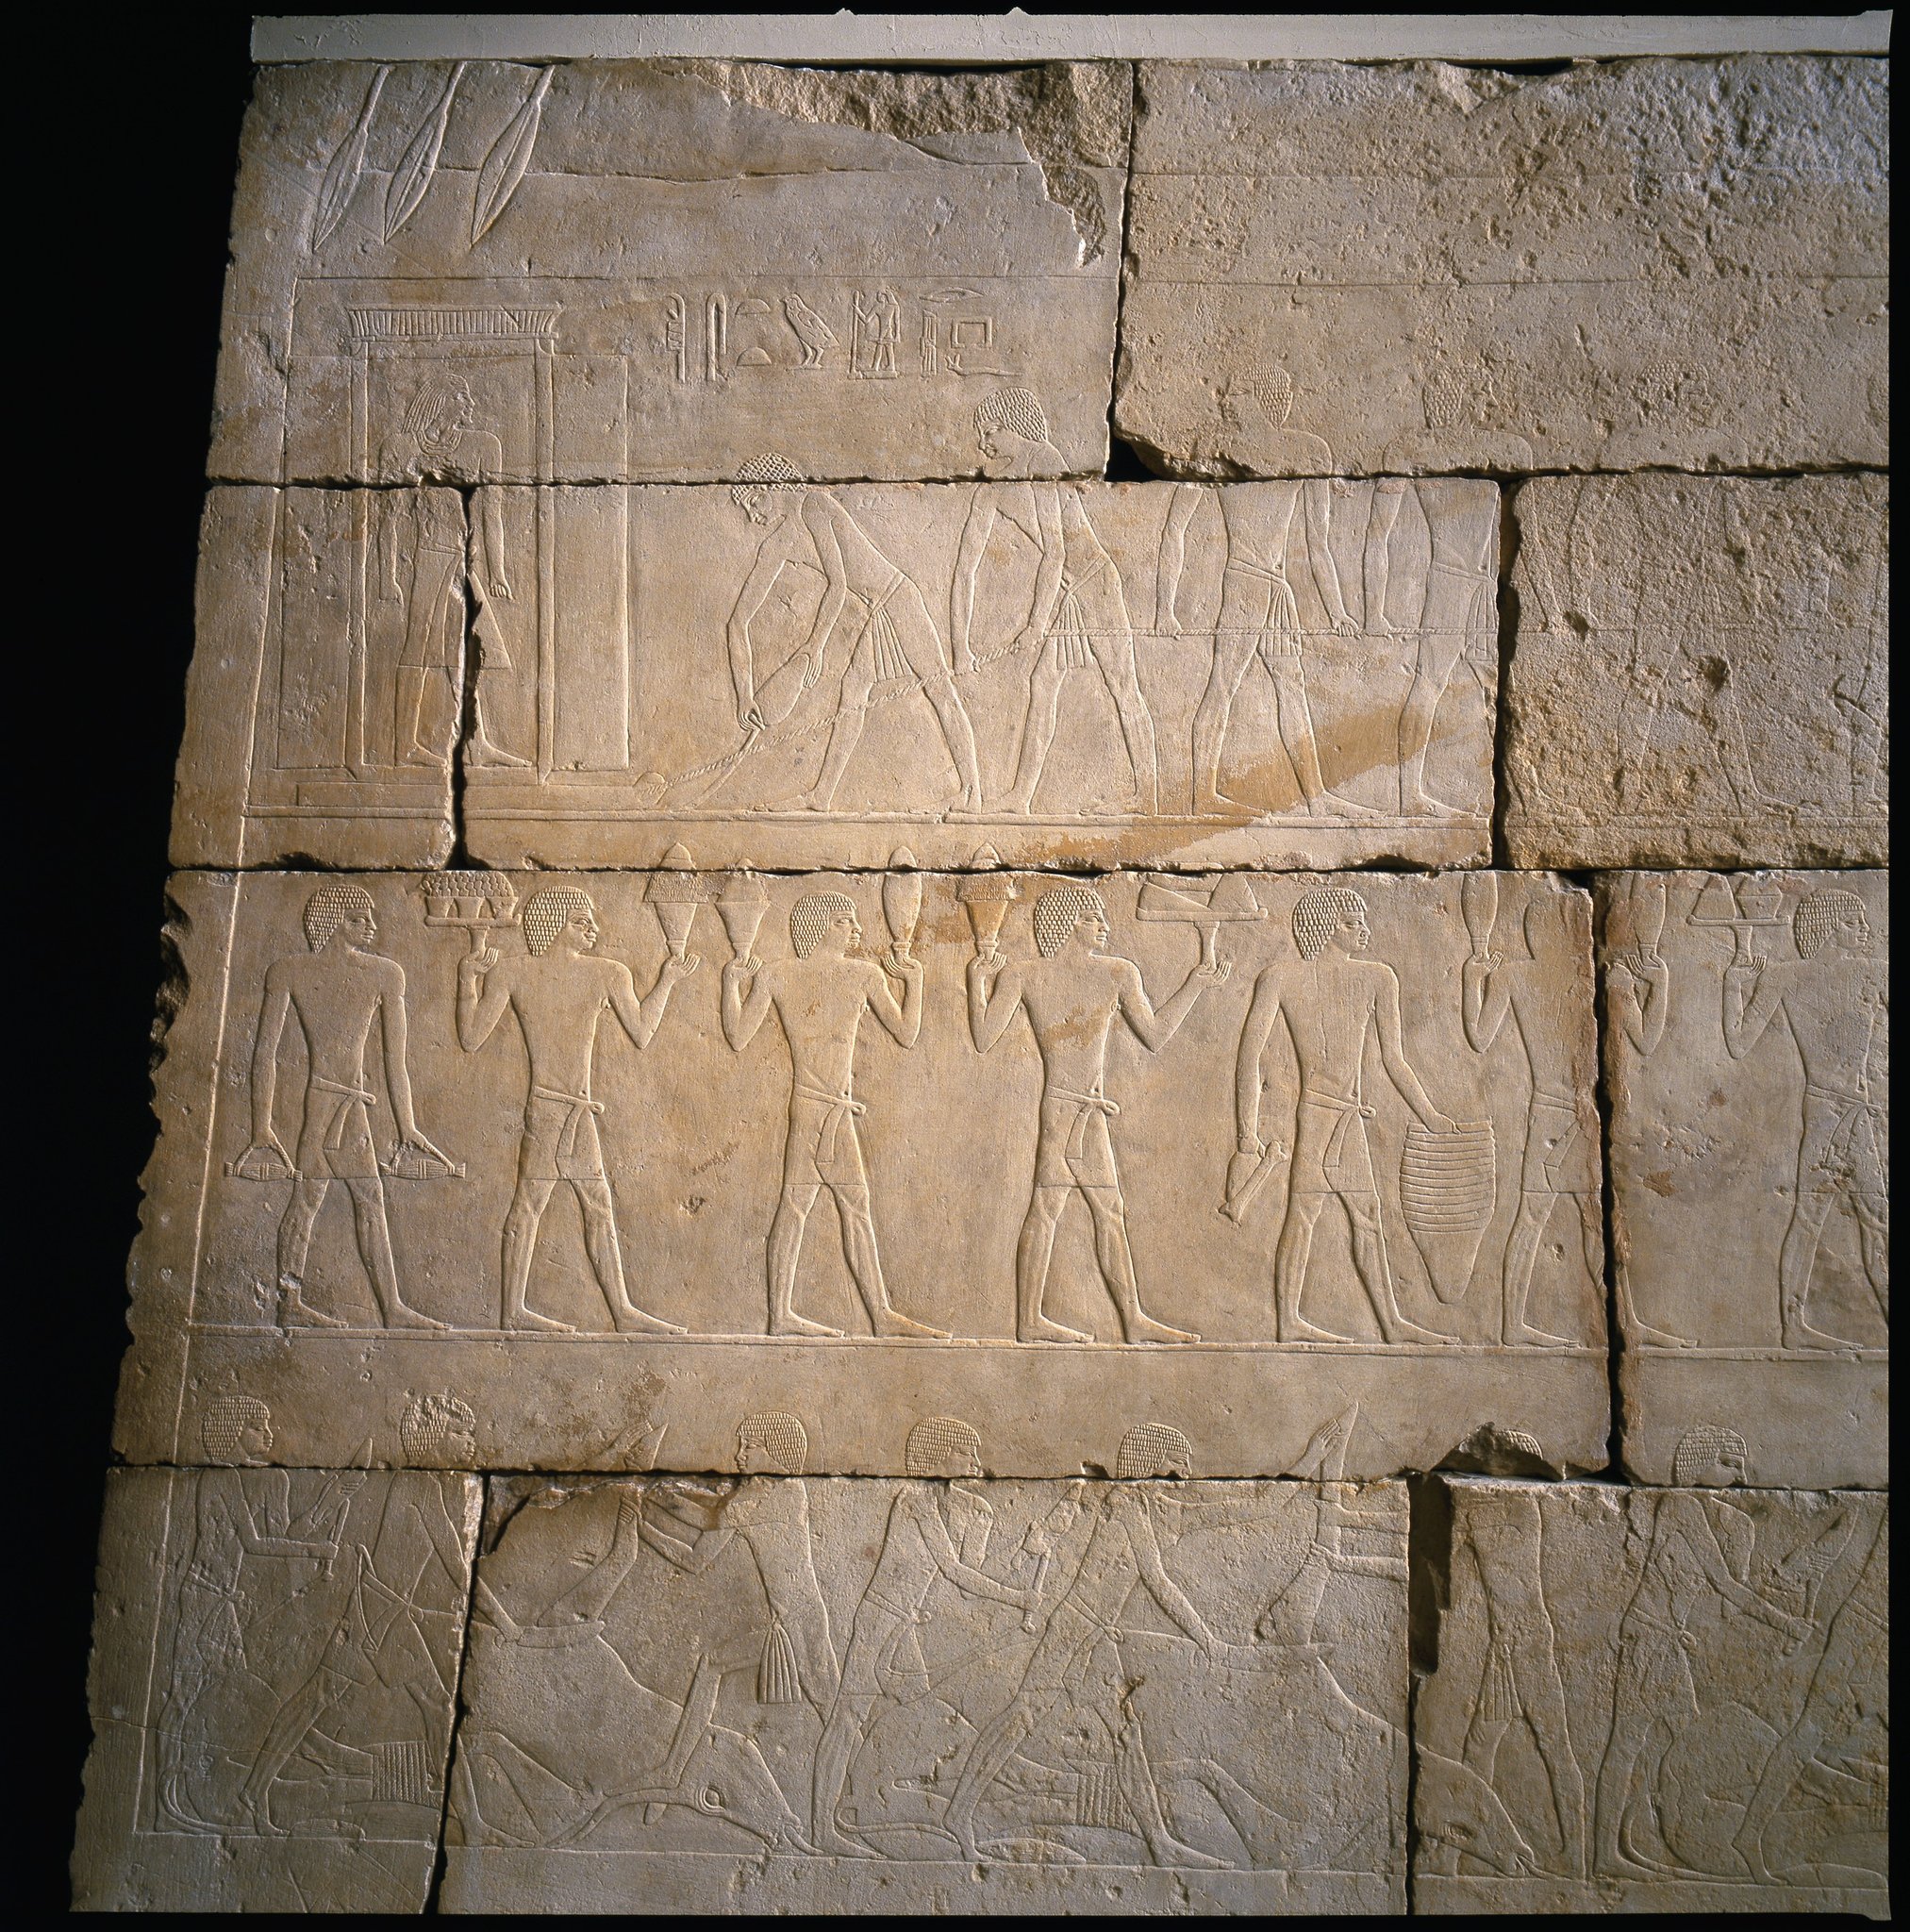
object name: relief, tomb chapel, raemkai, offering bearer, statue, slaughtering cattle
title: Tomb chapel of Raemkai: South wall of the entrance corridor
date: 2446-2389 BCE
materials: limestone, paint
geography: egypt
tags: animals,men